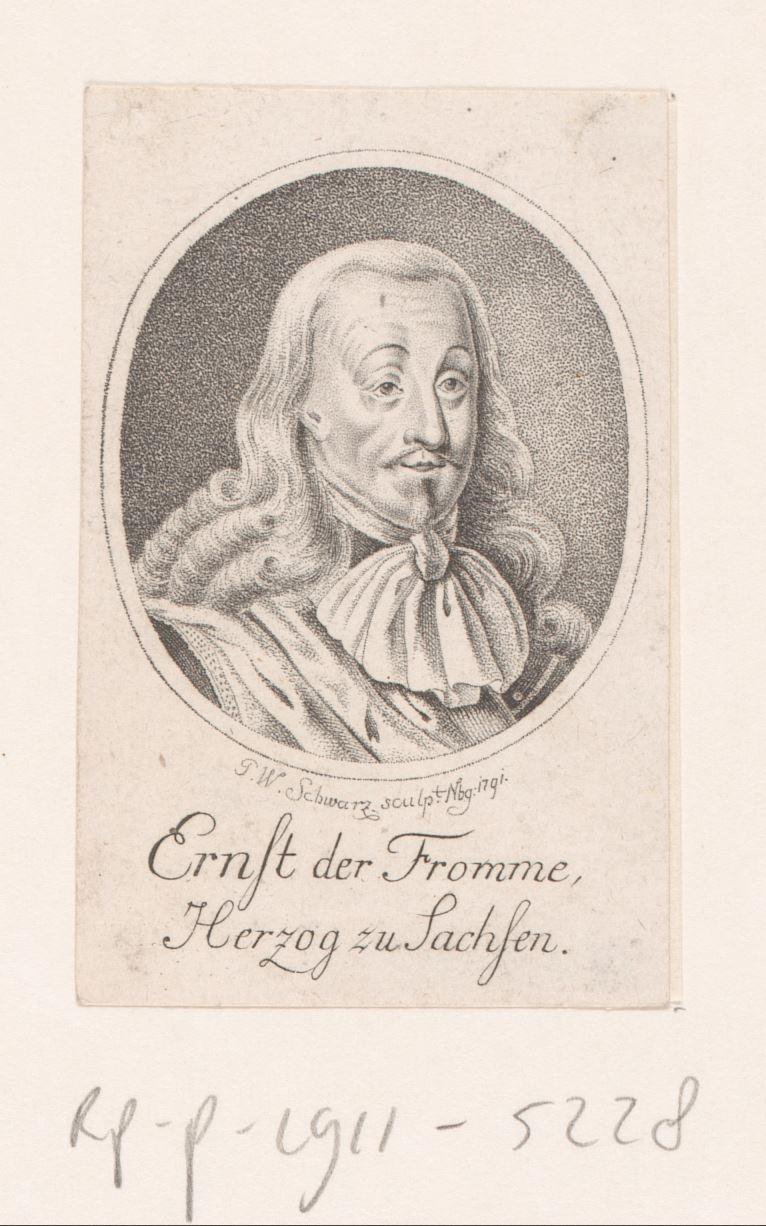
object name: print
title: Portret van Ernst I, hertog van Saksen-Gotha-Altenburg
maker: paul wolfgang schwarz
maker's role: print maker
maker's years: -1815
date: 1791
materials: paper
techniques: engraving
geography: nuremberg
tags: historical persons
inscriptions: collector's mark: Lugt 2228